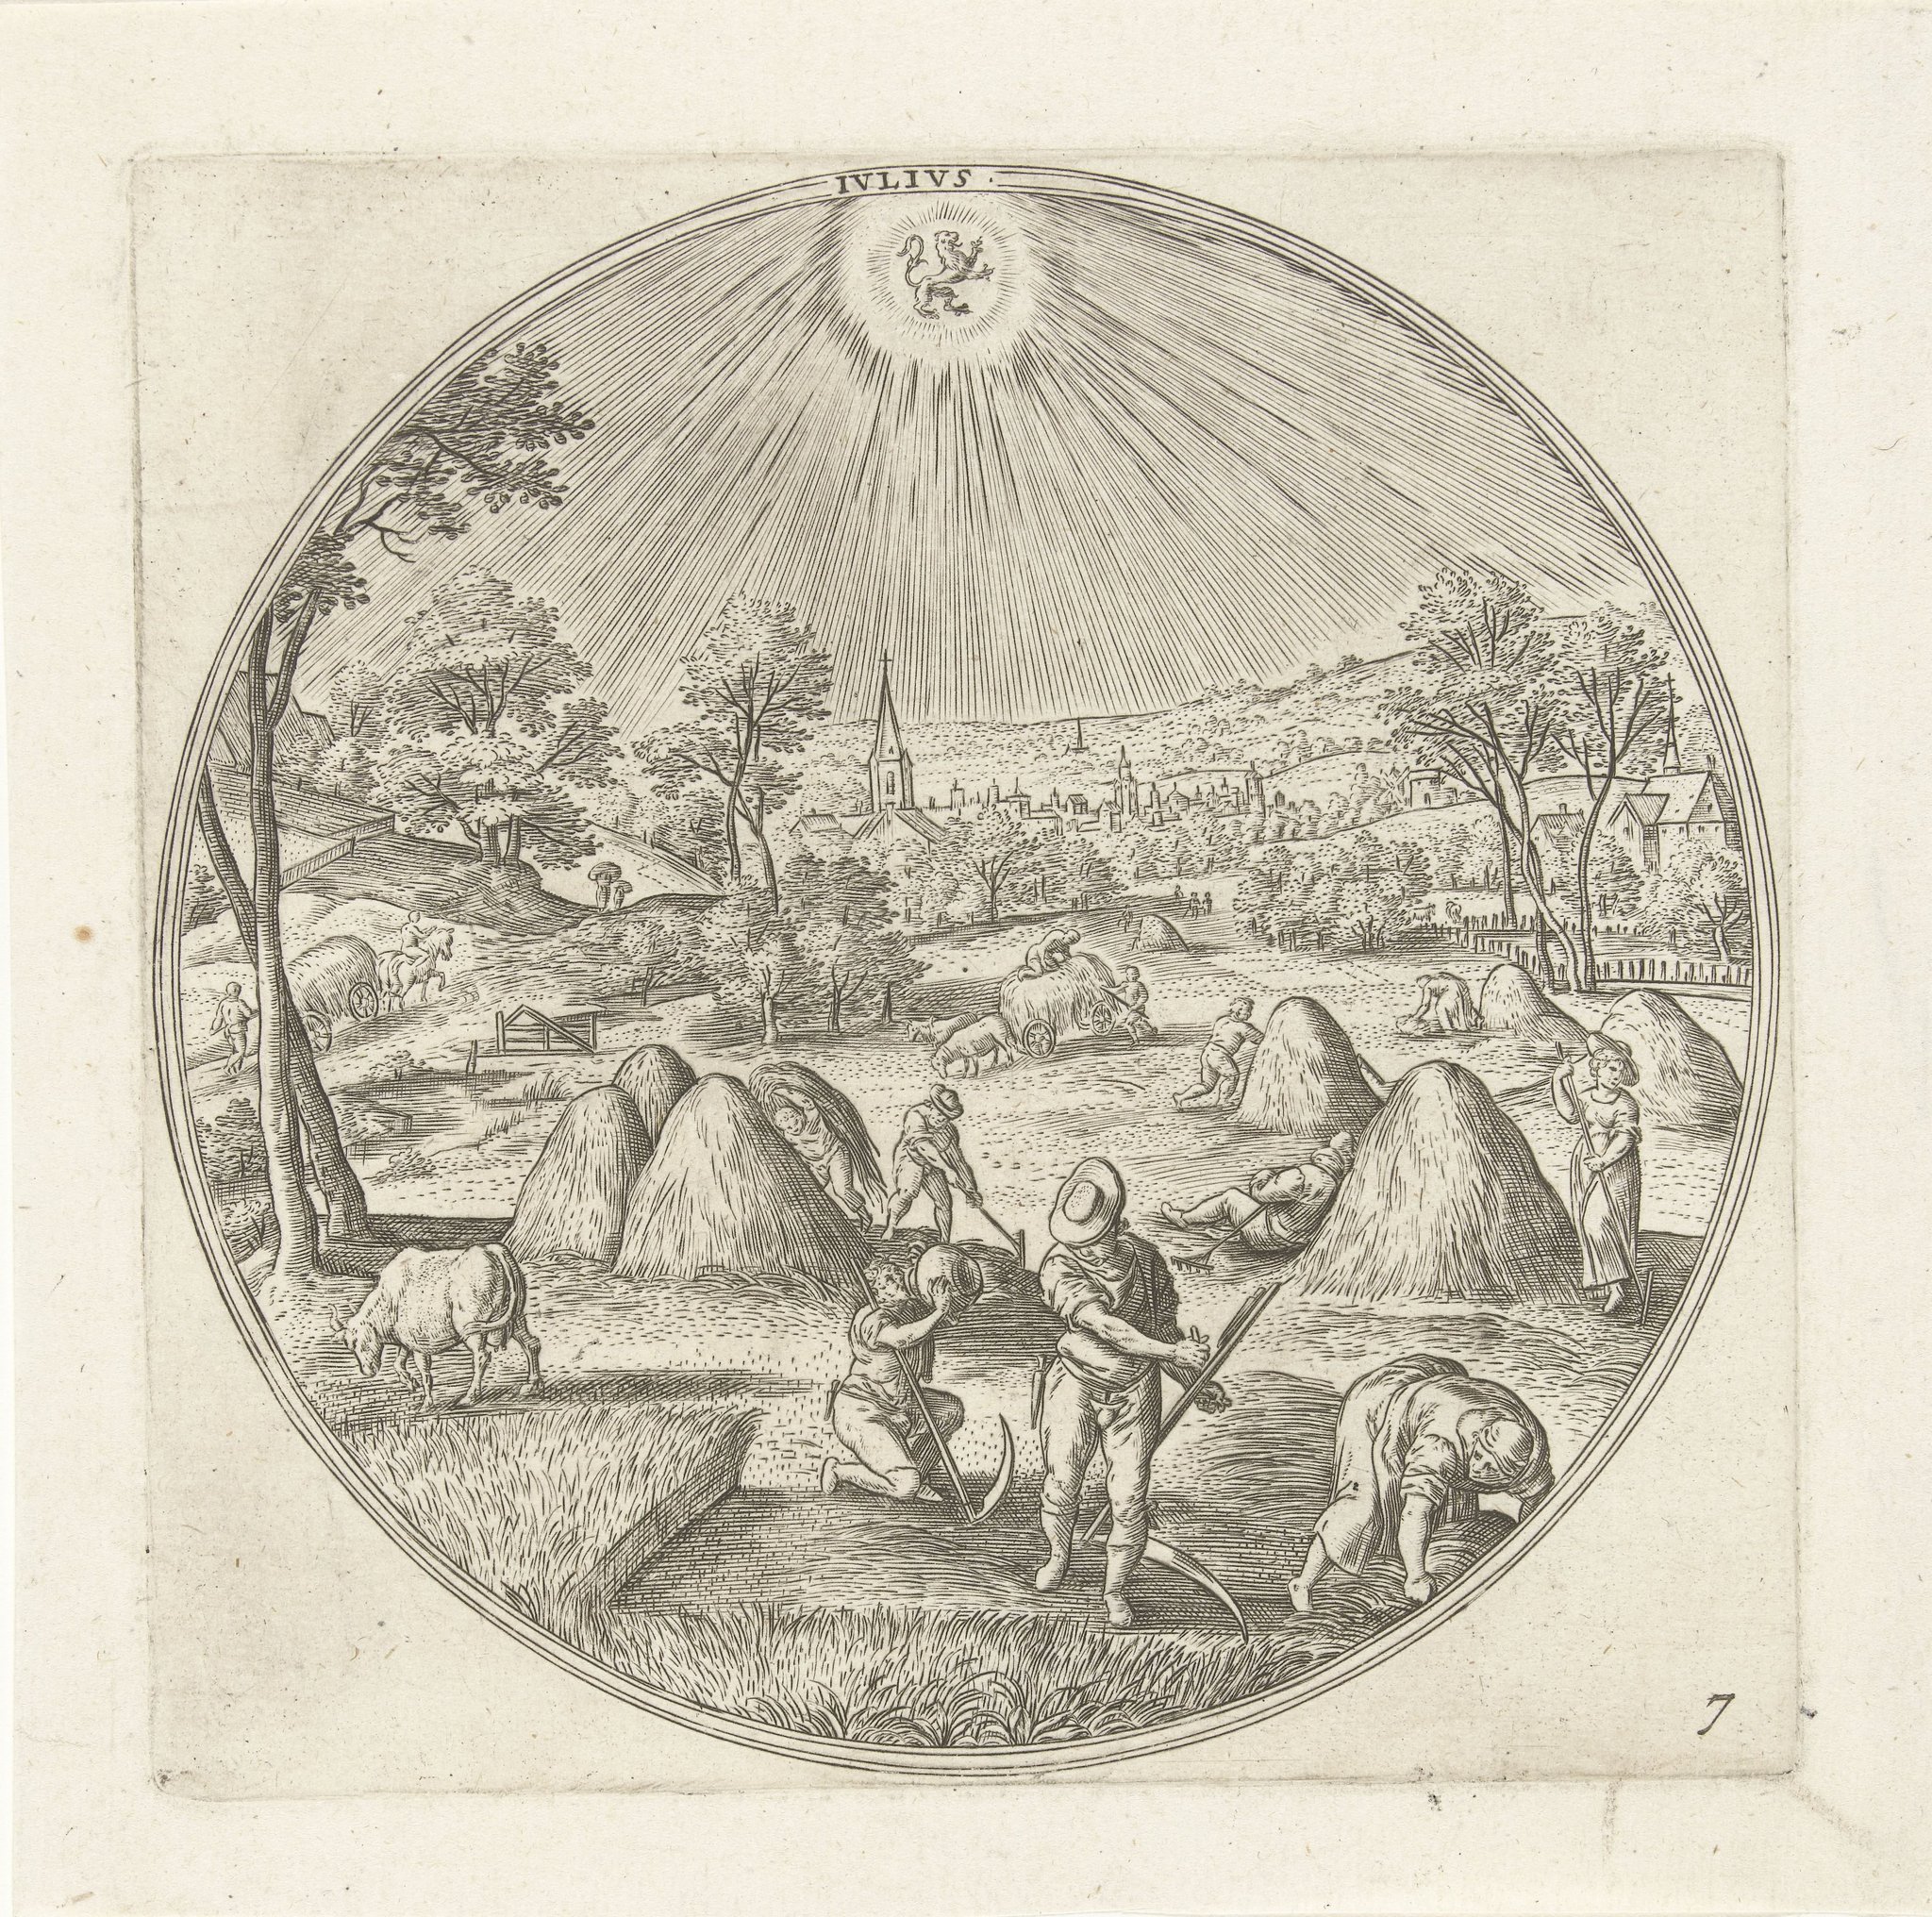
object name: print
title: Juli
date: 1578-1582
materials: paper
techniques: engraving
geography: antwerp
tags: hay-stack, hay-wagon, july and its 'labours' (+ with zodiacal signs), reaping, picking, mowing ~ harvest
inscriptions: collector's mark: Lugt 2228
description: Ronde lijst met zomerlandschap met zomertaferelen. Juli is de maai- of hooimaand. Centraal staat het hooien en het maaien van het gras. Hooiwagens brengen het gemaaide gras naar de schuur. Middenboven het sterrenbeeld Leeuw. De prent is deel van een twaalfdelige serie over de twaalf maanden.